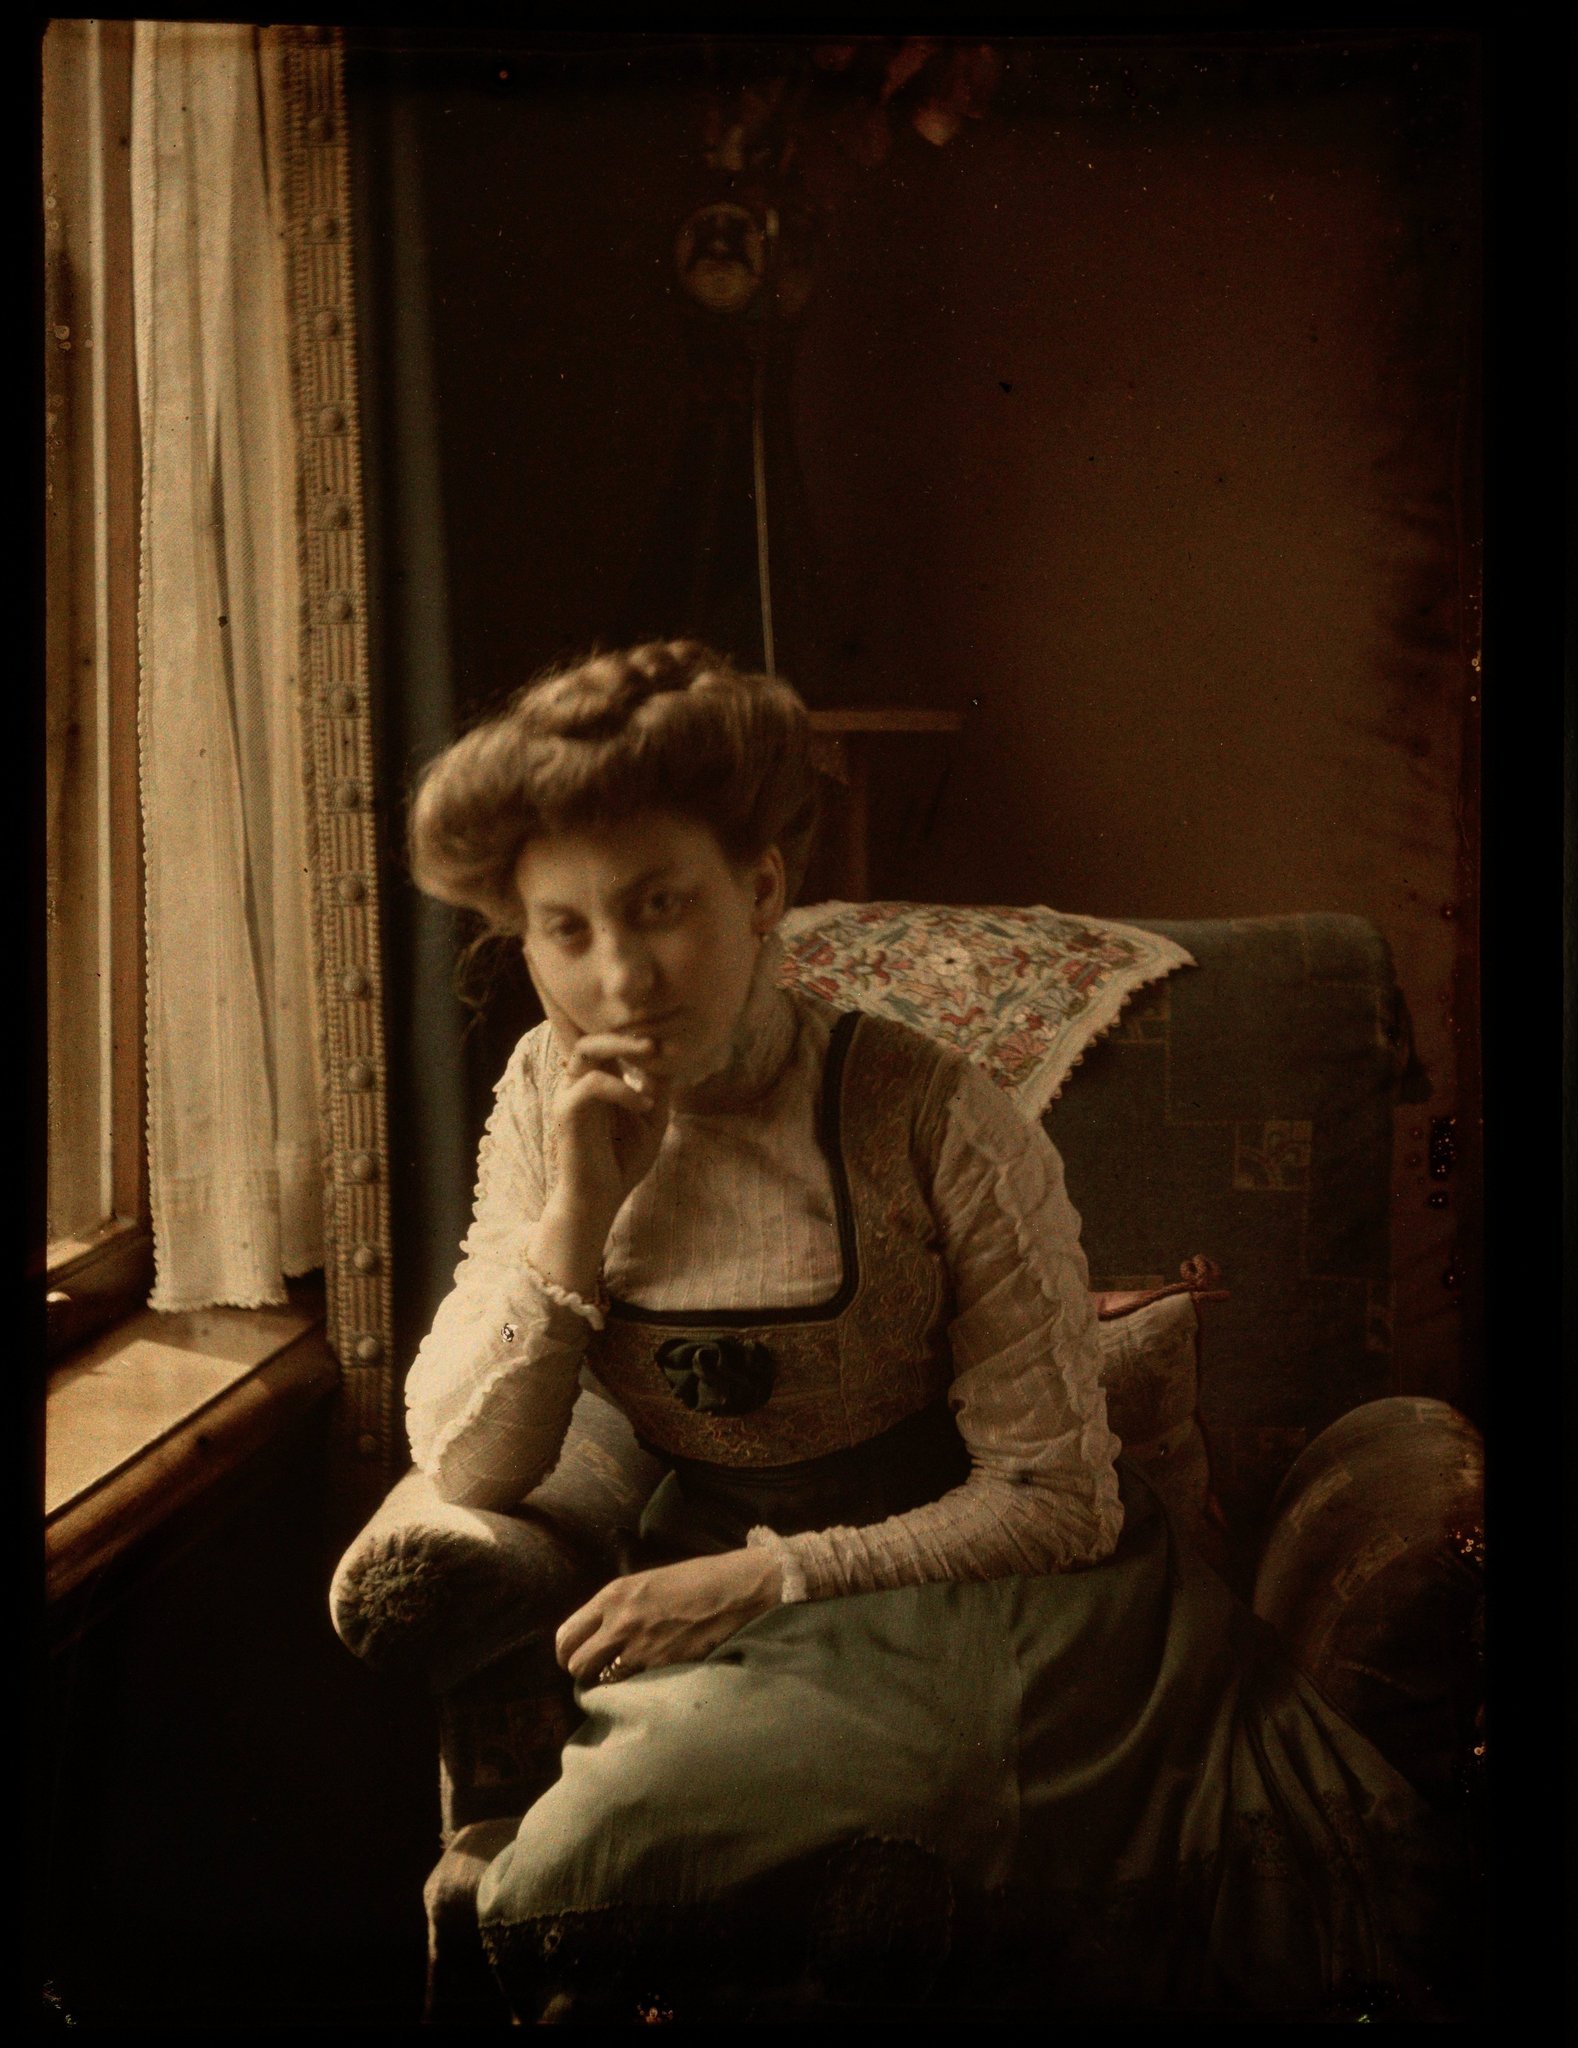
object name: photograph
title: Vrouw zittend bij het raam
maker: johannes hendrikus antonius maria lutz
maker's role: fotograaf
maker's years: -1916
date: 1907-1916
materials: glass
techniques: autochrome process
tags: armchair, seat, sitting figure - aa - female human figure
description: Interieur met jonge vrouw zittend bij het raam.